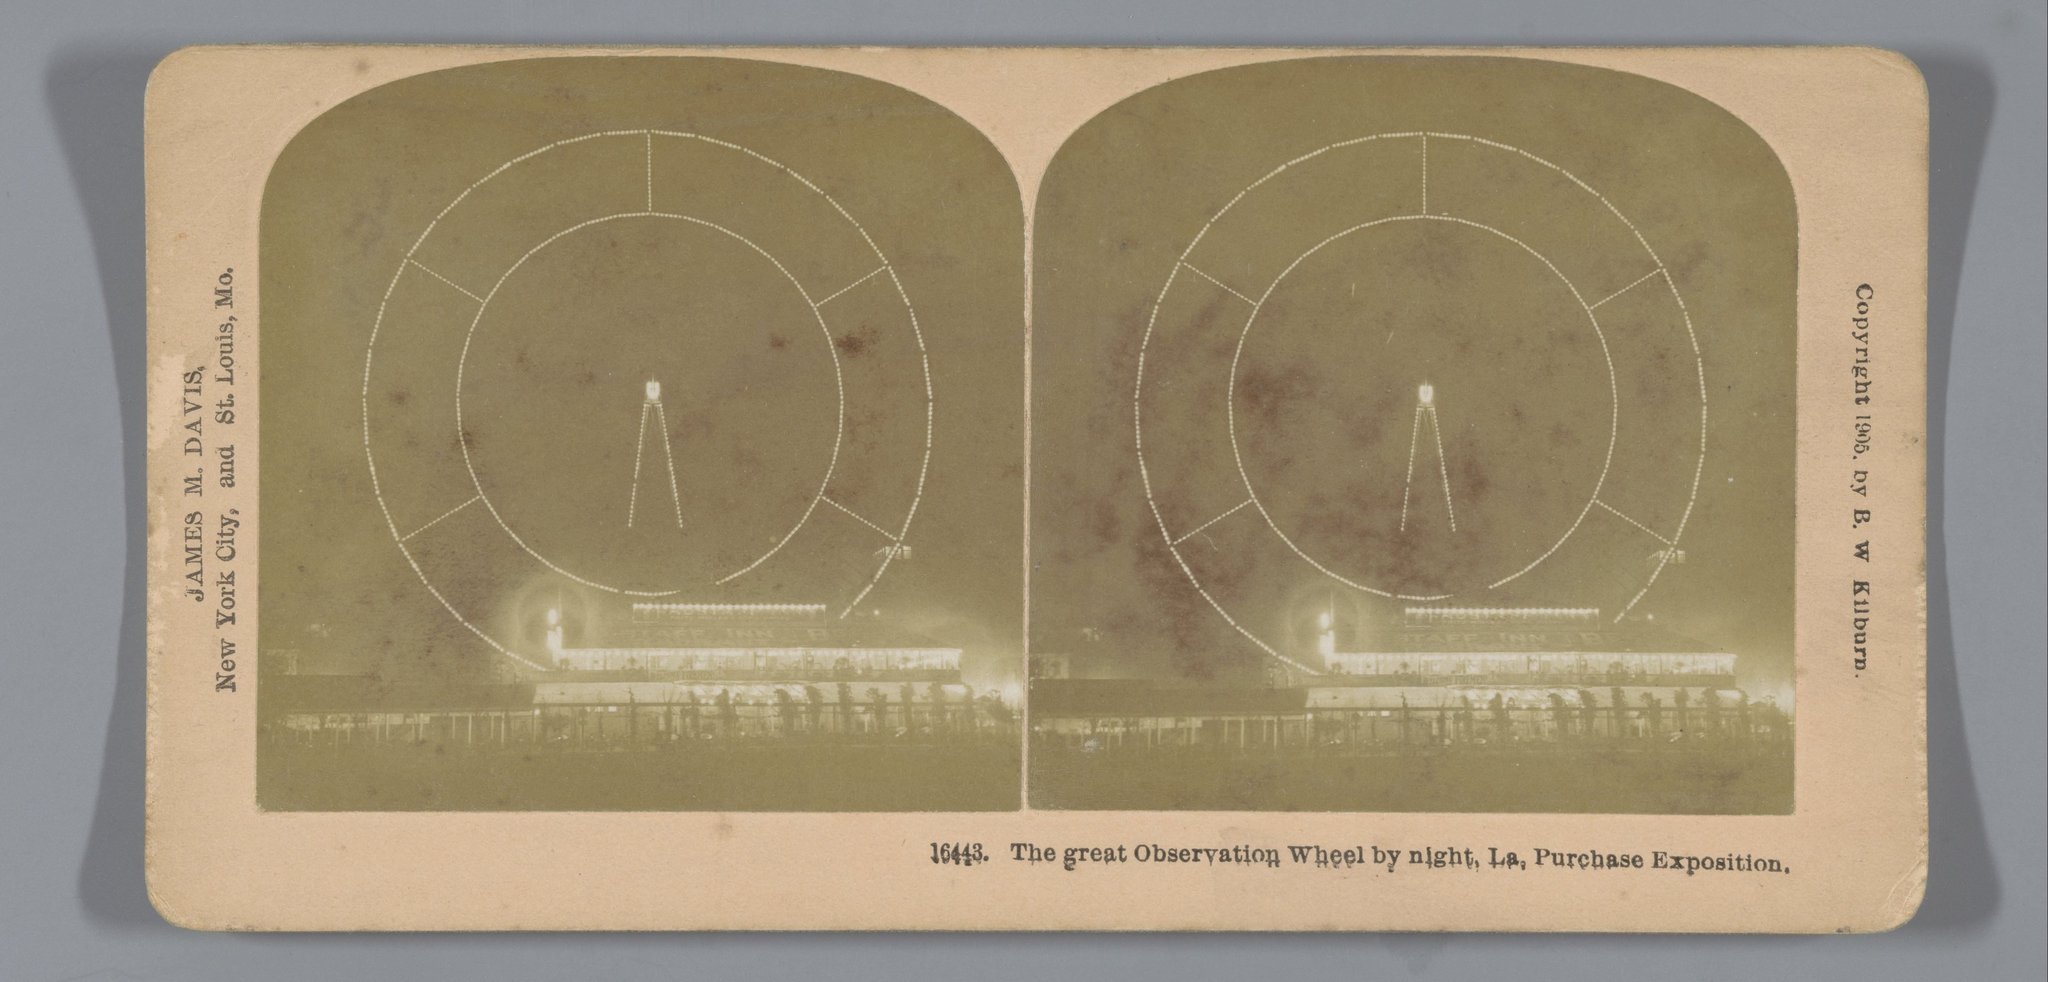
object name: stereograph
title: Reuzenrad op de Wereldtentoonstelling van 1904 in Saint Louis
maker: benjamin west kilburn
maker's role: fotograaf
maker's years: 1827-1909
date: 1904-1905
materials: cardboard, paper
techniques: albumen print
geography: saint louis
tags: world fair, world exhibition, giant wheel, ferris wheel, artificial light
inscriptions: number: ‘16443.’, copyright notice: ‘Copyright 1905, by B.W. Kilburn.’